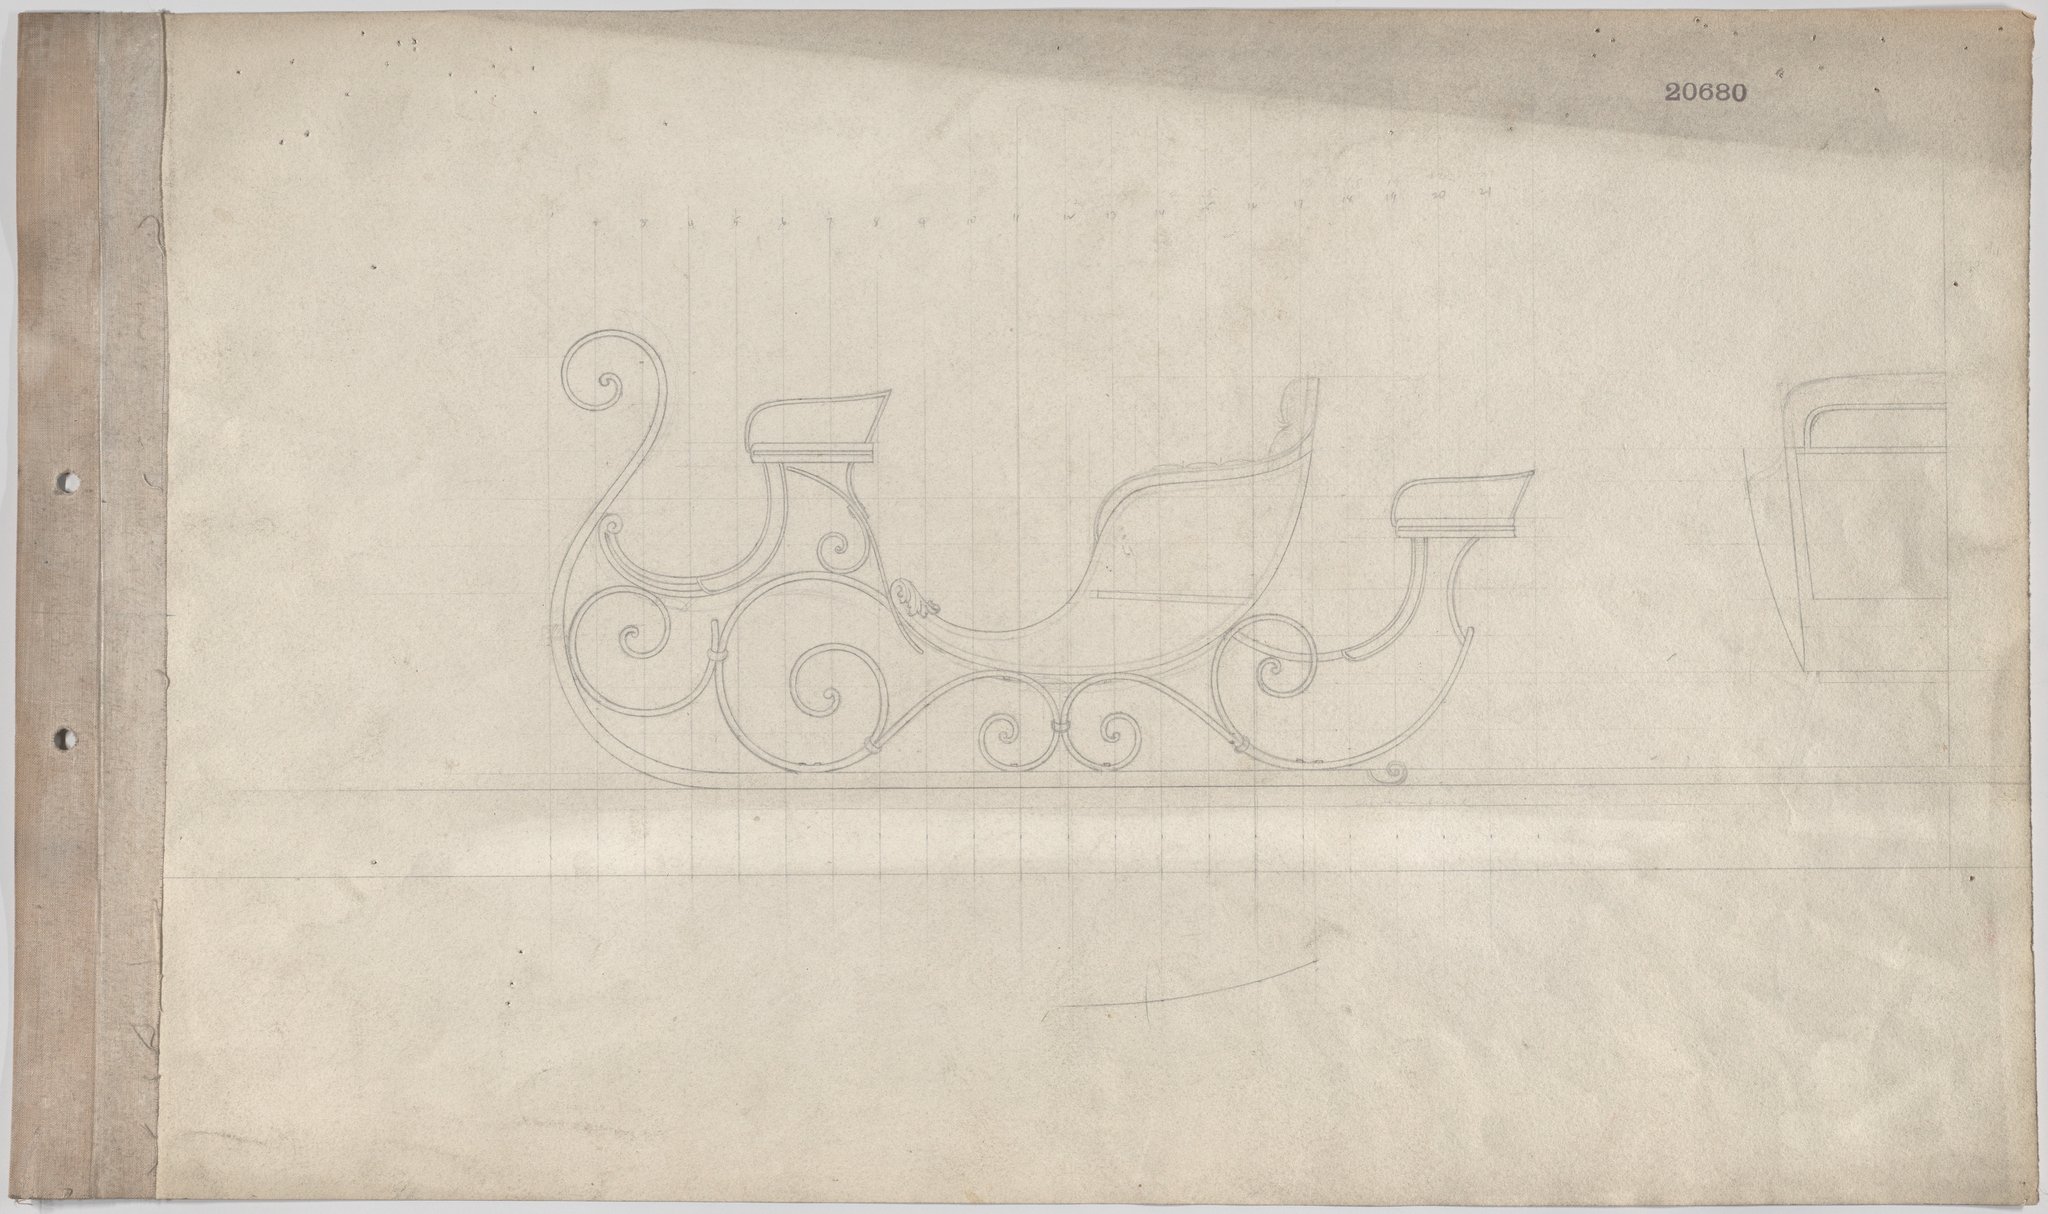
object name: drawing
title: Victoria Sleigh #20680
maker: brewster & co.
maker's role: manufacturer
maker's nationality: american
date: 1894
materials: graphite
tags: sleighs